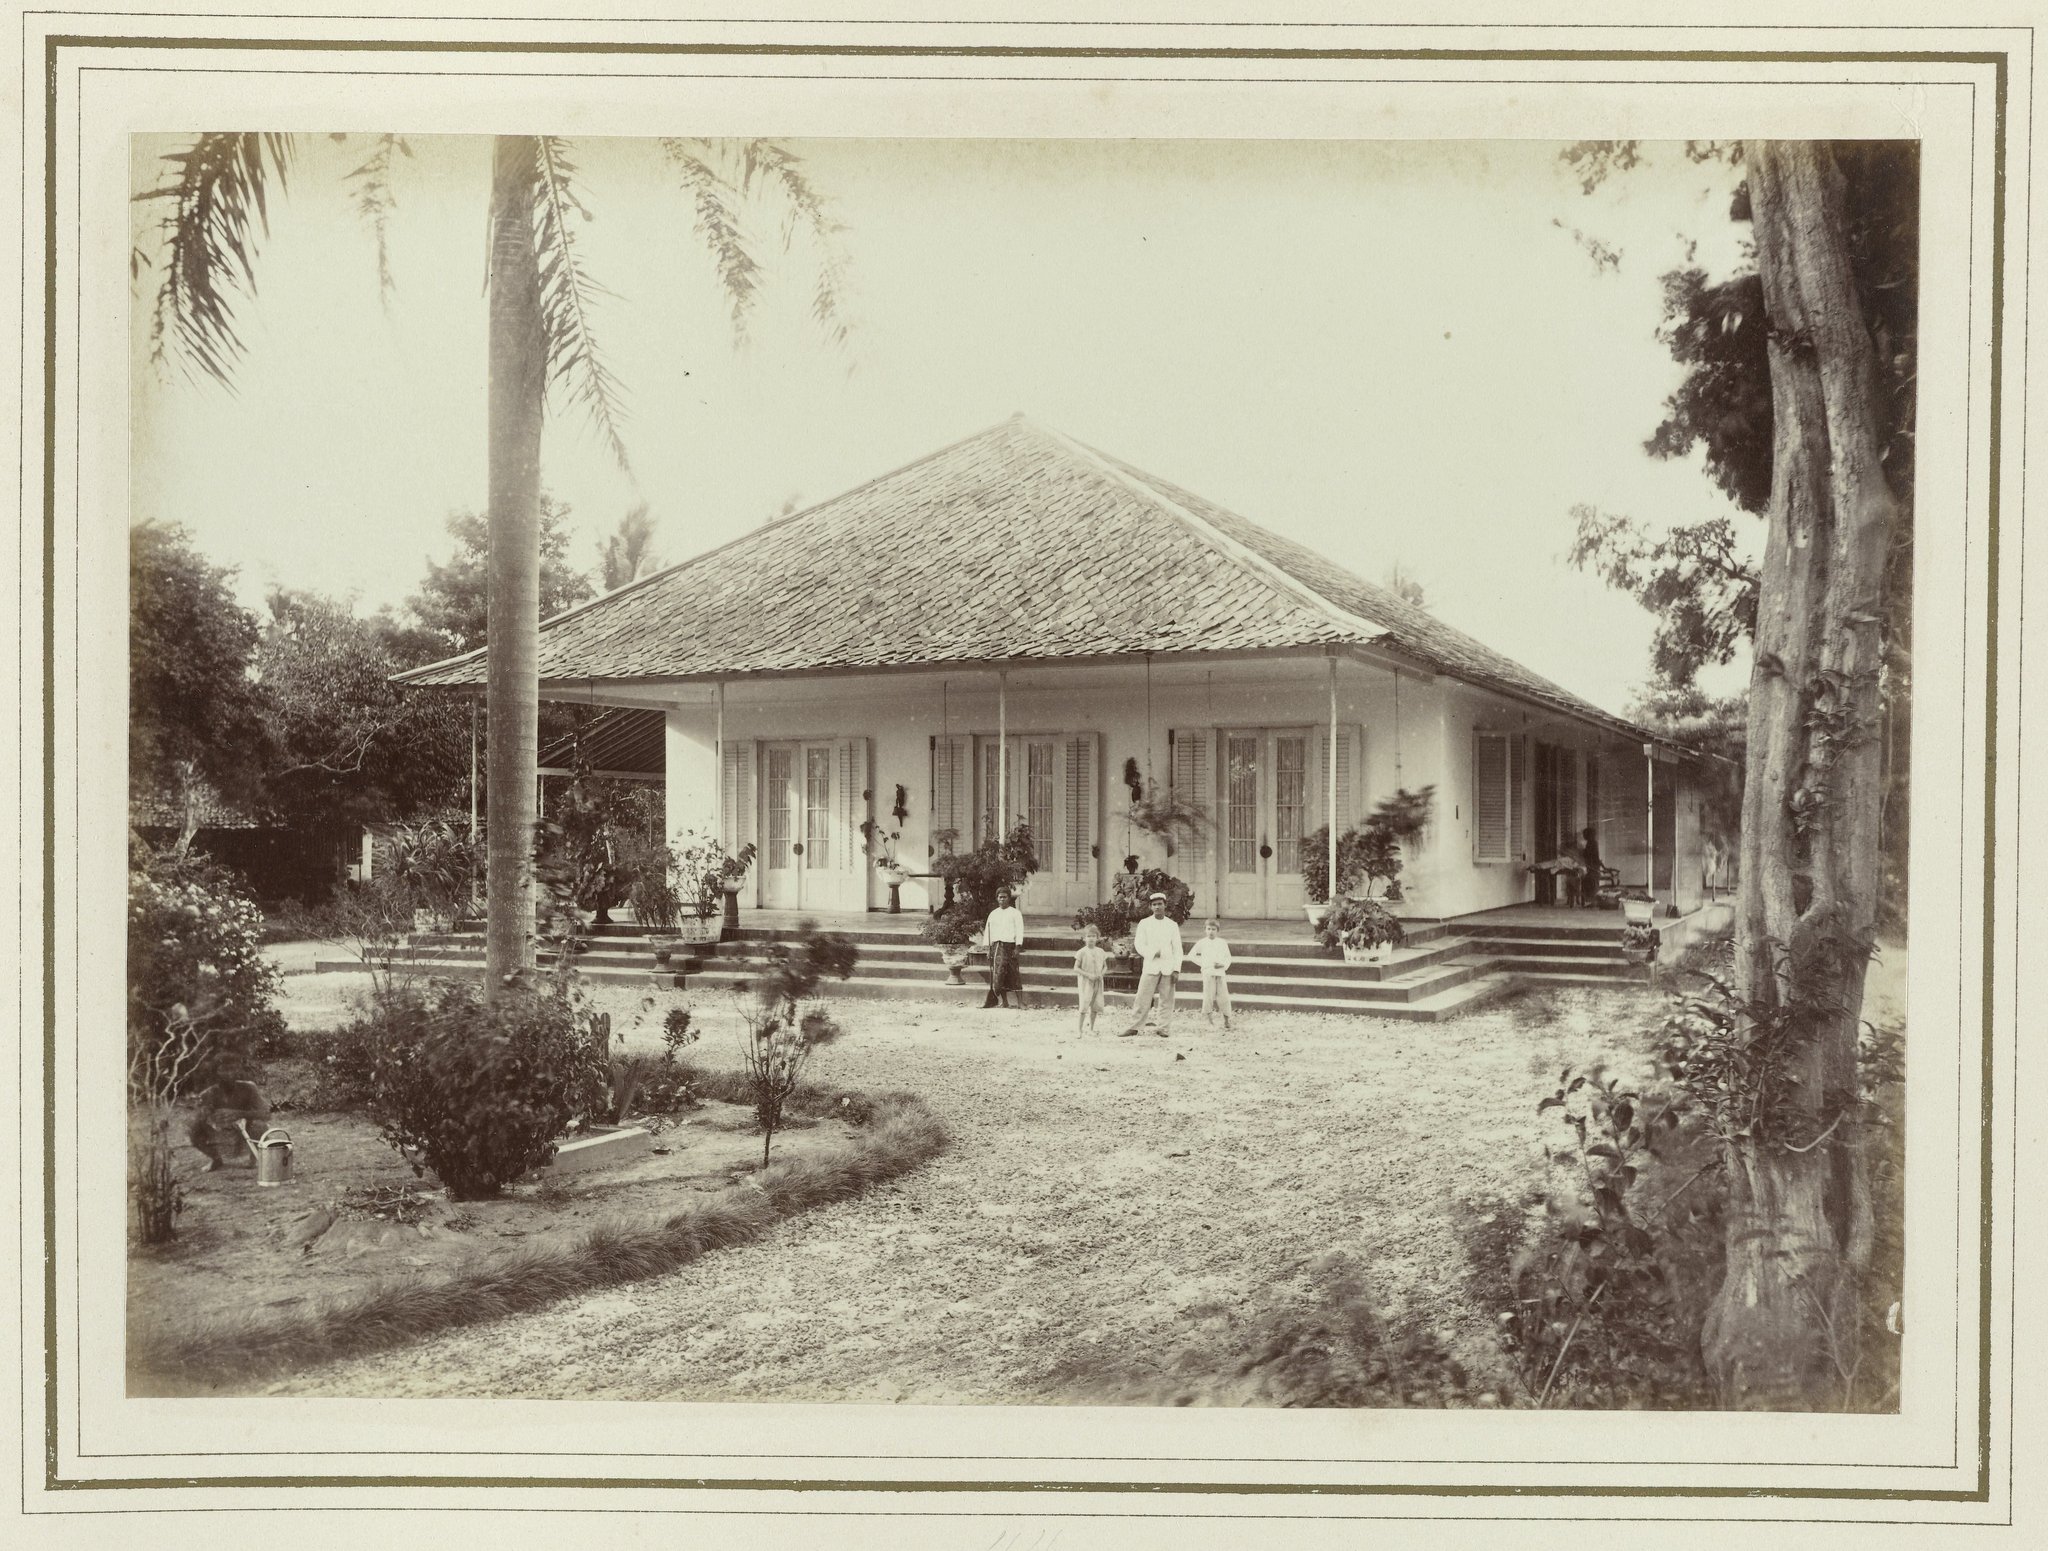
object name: photograph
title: Woonhuis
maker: kassian céphas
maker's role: fotograaf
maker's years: 1845-1912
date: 1886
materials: photographic support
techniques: albumen print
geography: jogjakarta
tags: villa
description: Een woonhuis met tuin. Voor het huis staan enkele Europese kinderen en een Indische bediende. Onderdeel van het fotoalbum aangeboden aan J.M. Pijnacker Hordijk bij zijn vertrek uit Jogyakarta in 1886.